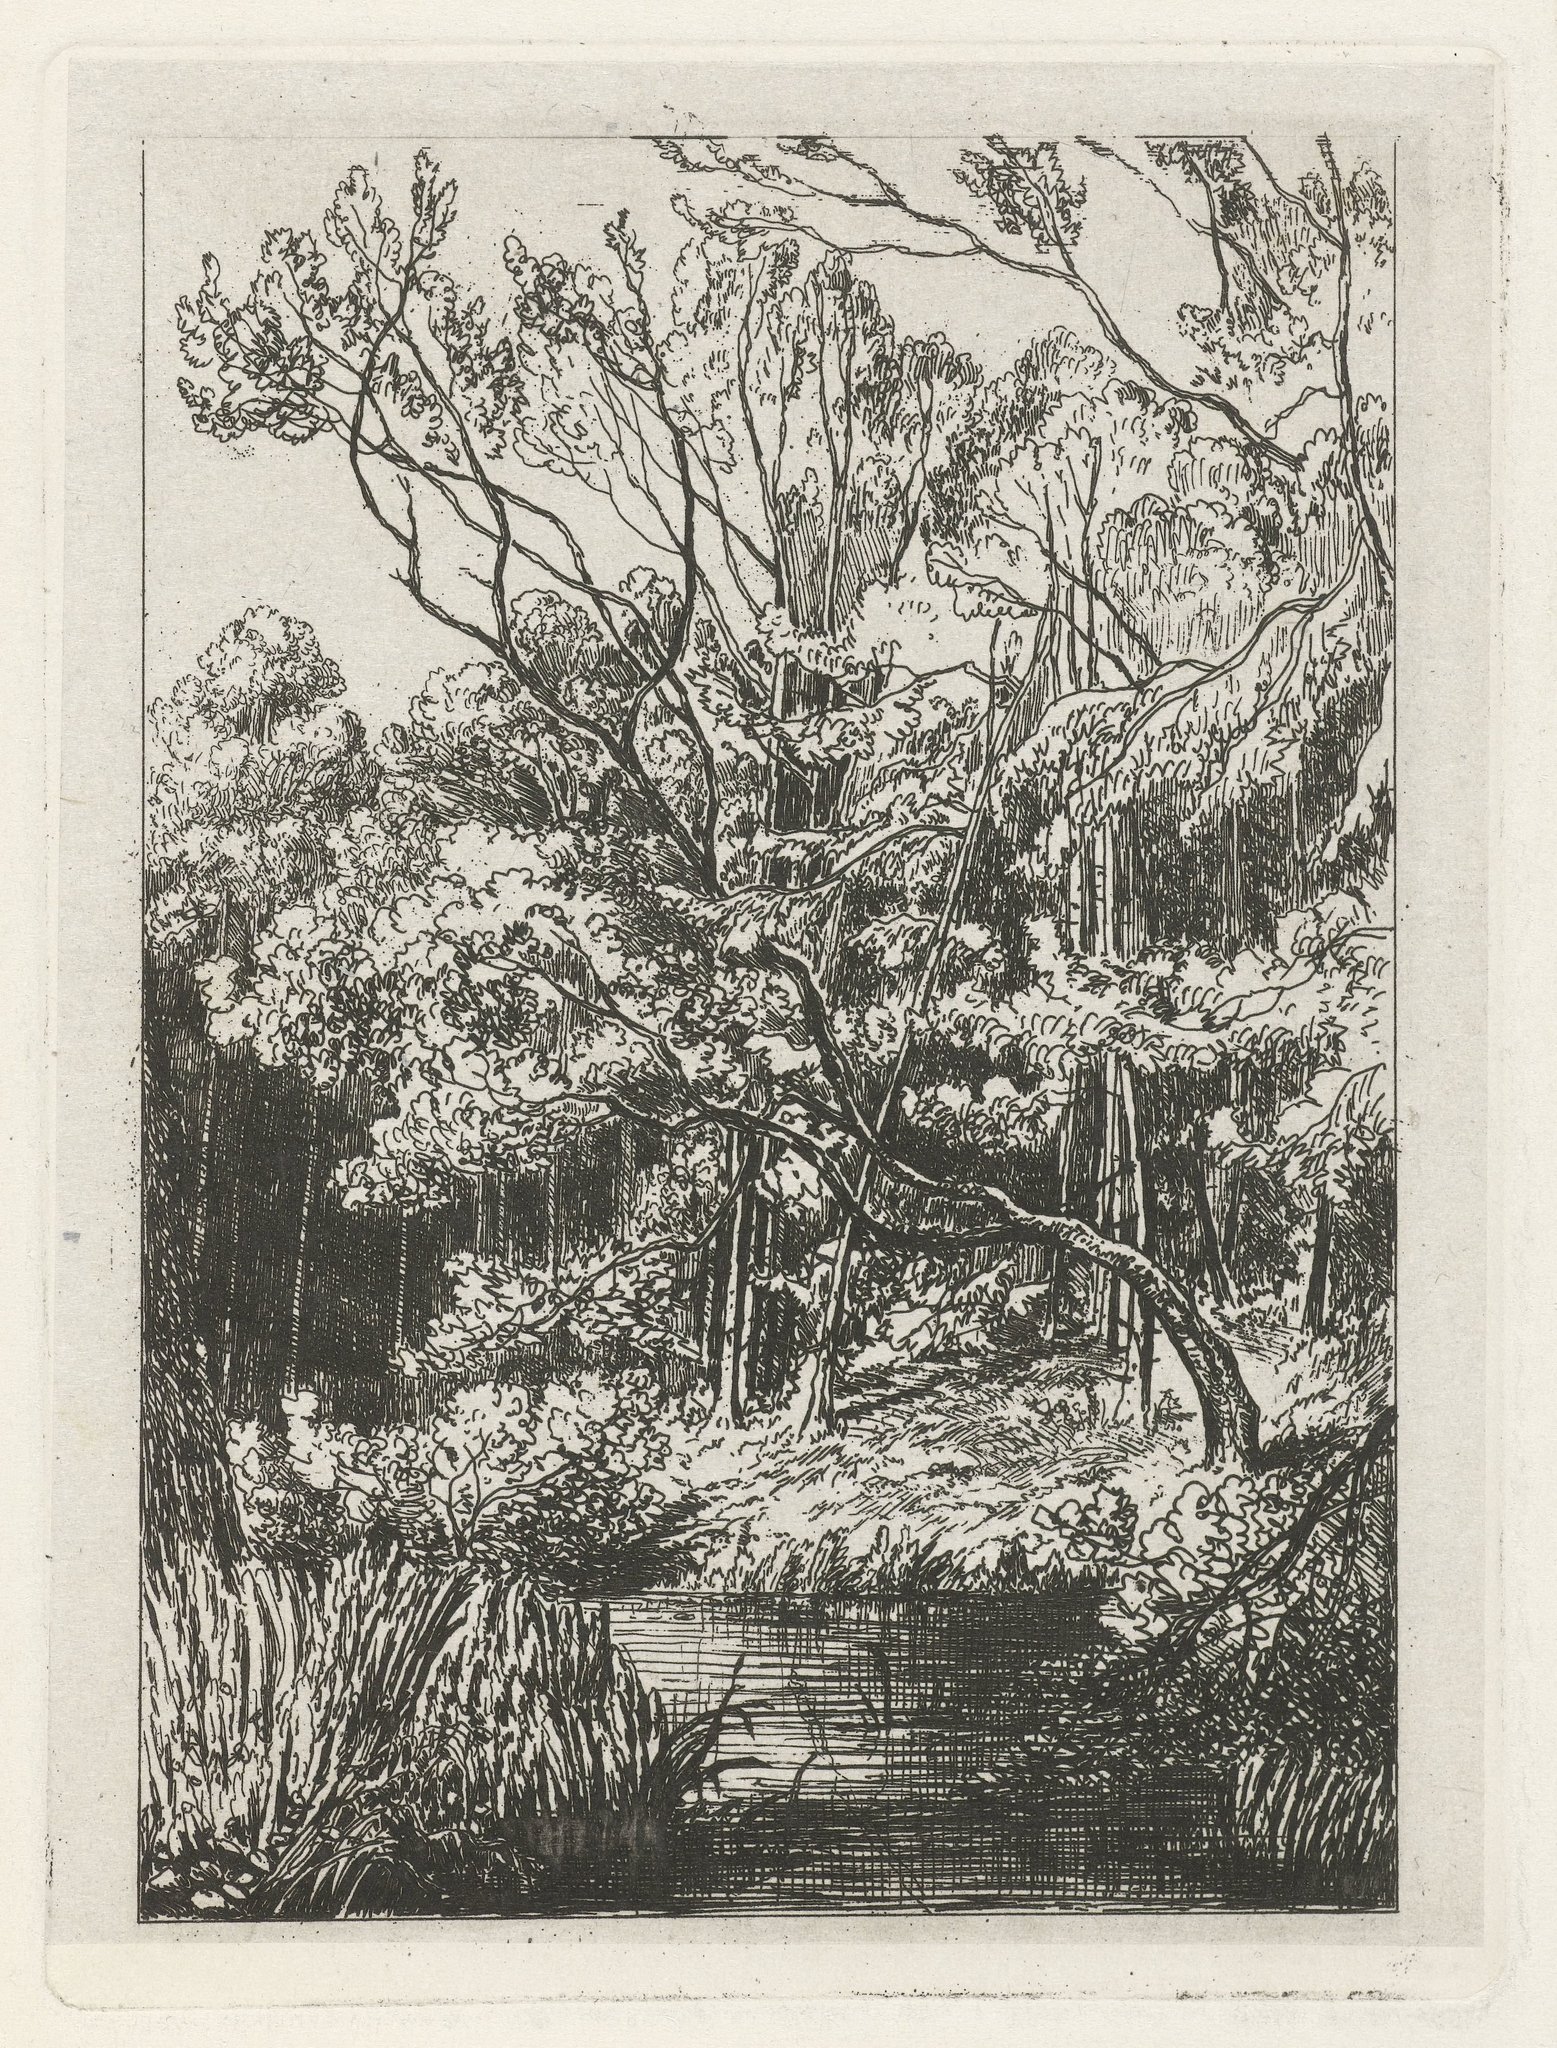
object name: print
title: Bosgezicht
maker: joseph hartogensis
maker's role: painter, print maker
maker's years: 1822-1865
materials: paper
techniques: etching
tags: water course, forest, wood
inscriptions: collector's mark: Lugt 2228